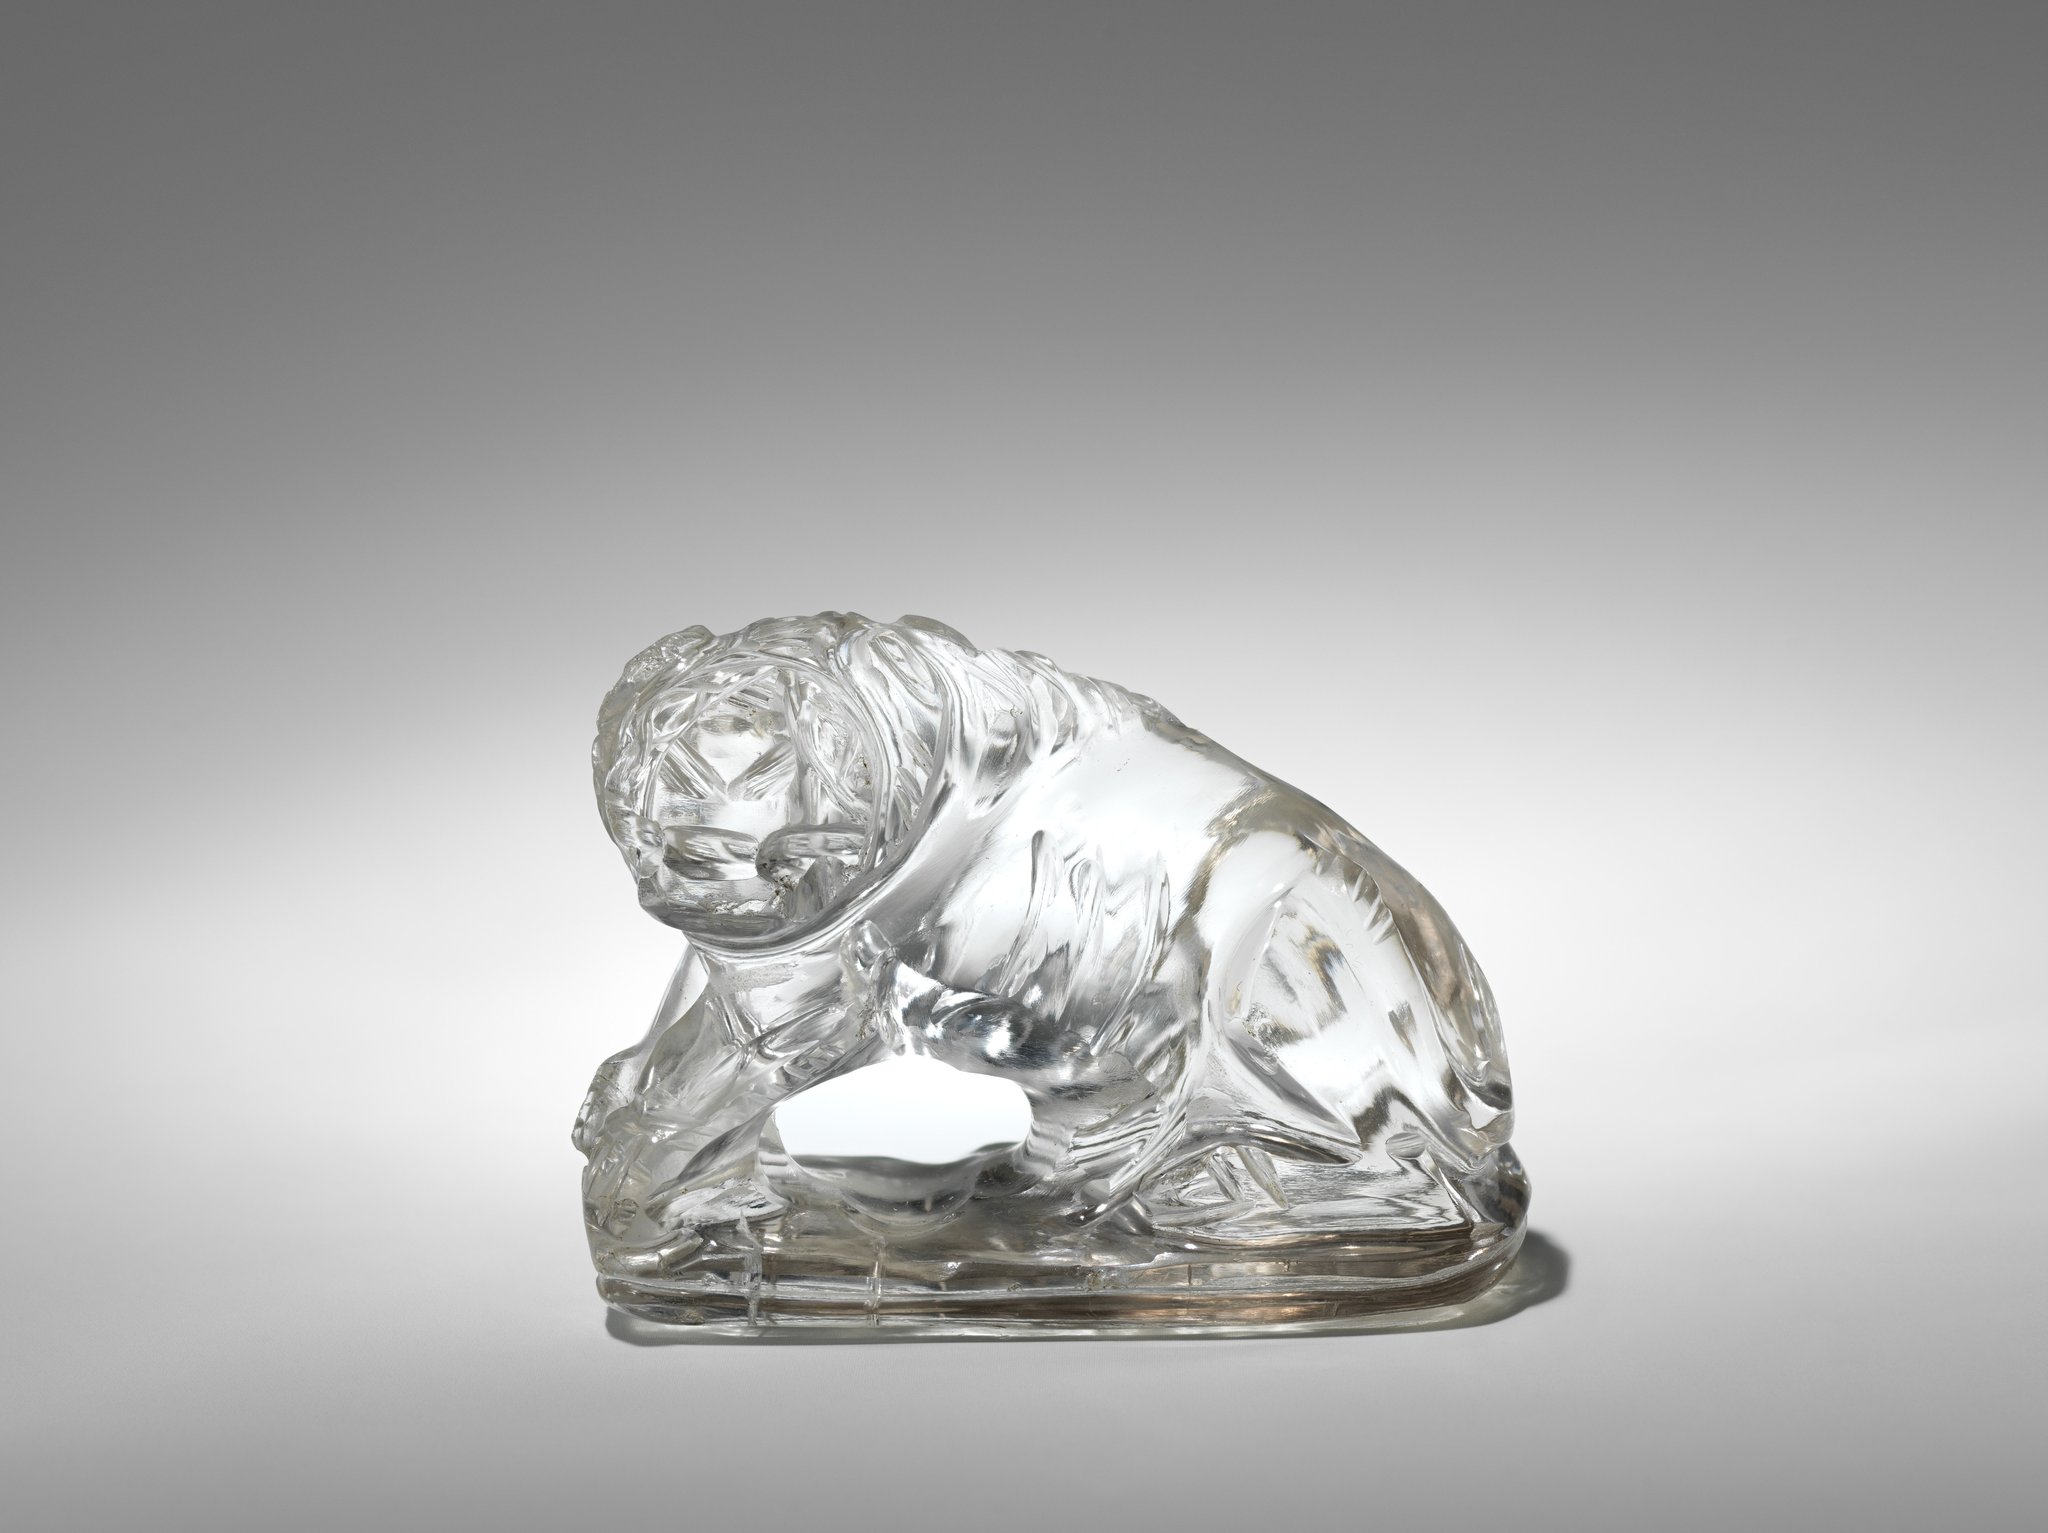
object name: statuette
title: Rock crystal Statuette of a Lion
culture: north african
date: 201-400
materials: quartz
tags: lions